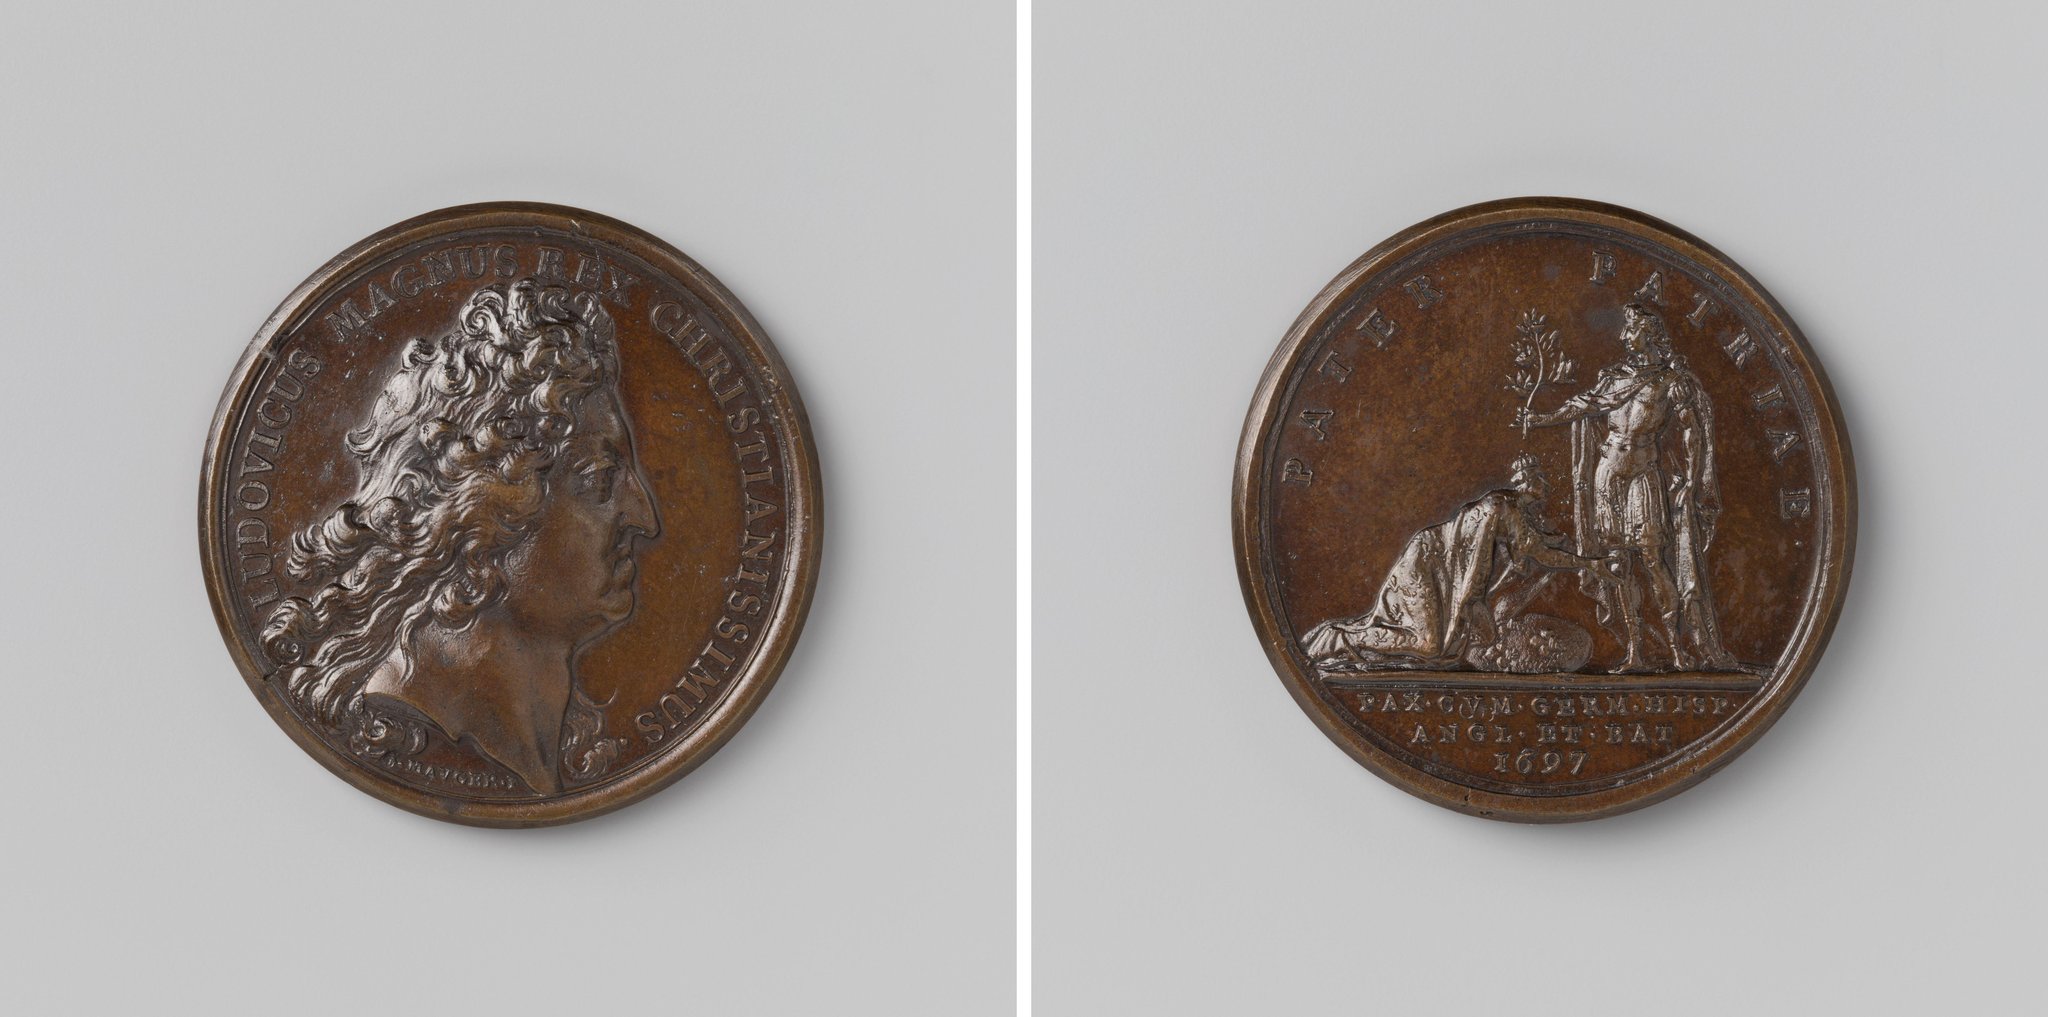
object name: history medal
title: Vrede van Rijswijk, ter ere van Lodewijk XIV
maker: jean mauger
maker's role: medailleur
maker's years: 1648-1722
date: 1699-1703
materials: bronze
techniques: striking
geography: paris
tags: lodewijk xiv (koning van frankrijk)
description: Bronzen penning. Voorzijde: borststuk man binnen omschrift. Keerzijde: Lodewijk, in Romeins tenue schenkt aan Frankrijk, in gedaante van knielende vrouw met wapenschild vredestak binnen omschrift; afsnede: opschrift